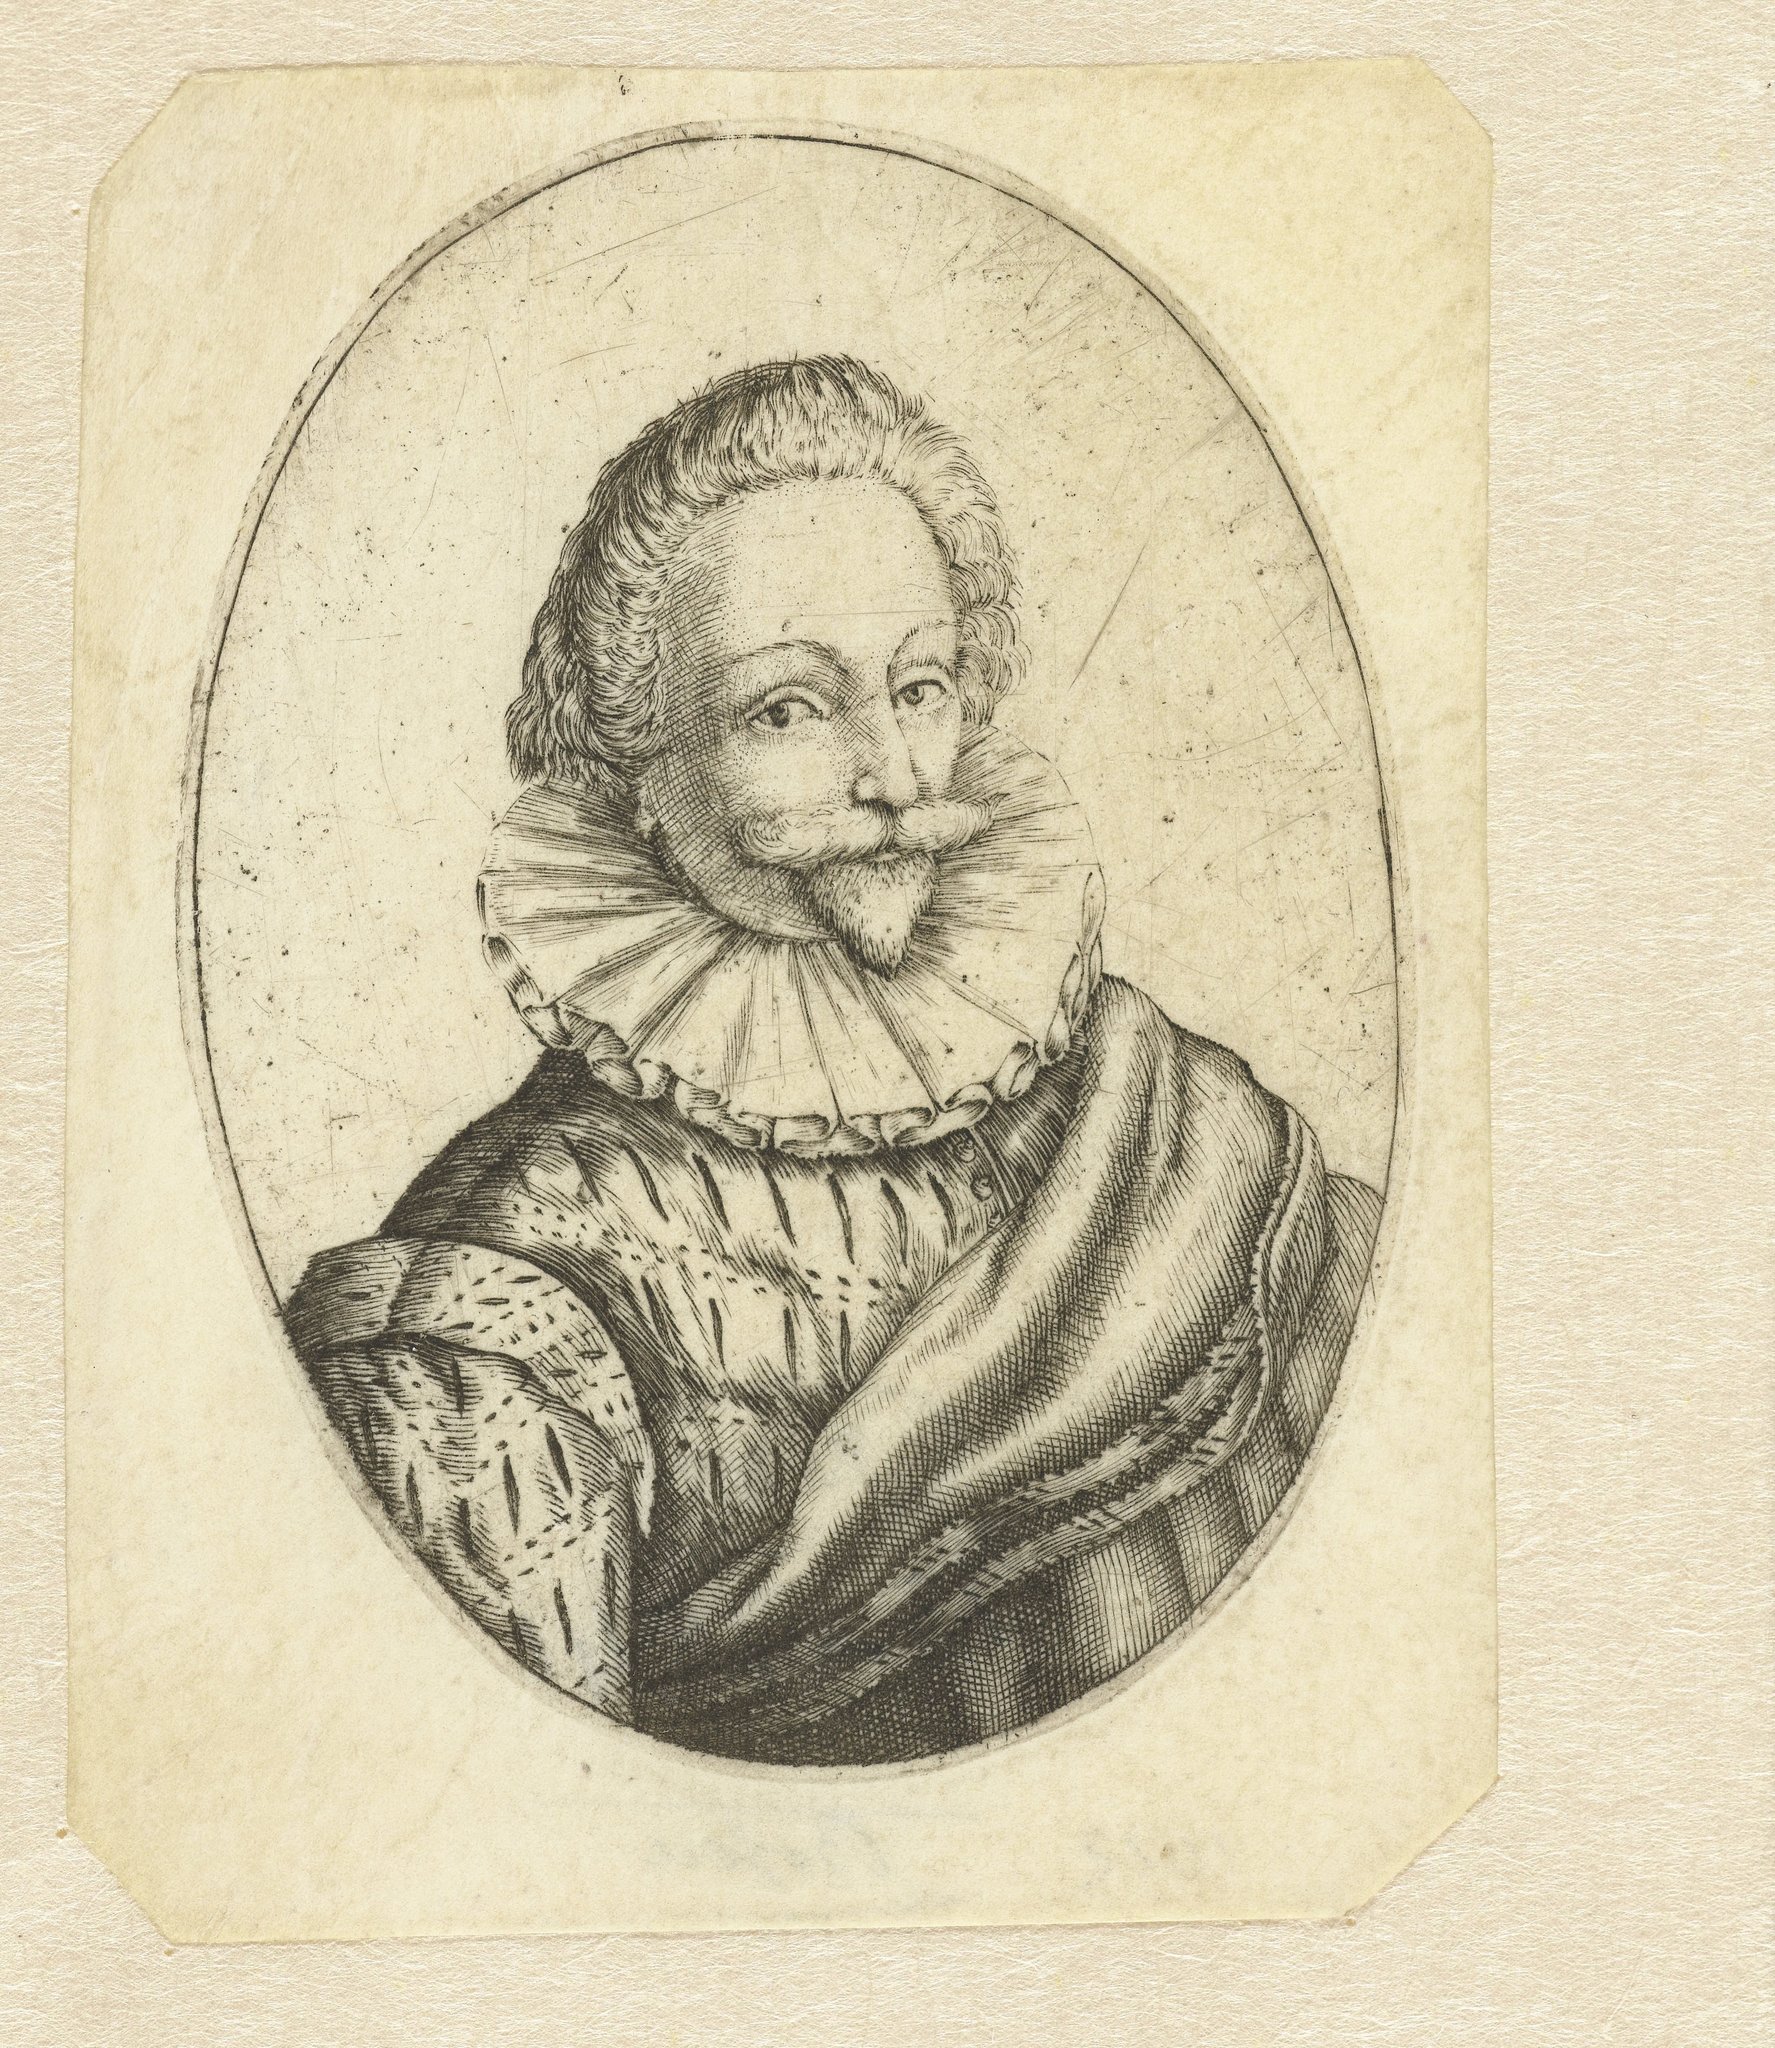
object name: print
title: Portret van een man met snor en baard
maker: Anonymous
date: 1600-1640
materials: parchment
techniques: engraving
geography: netherlands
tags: anonymous historical person portrayed alone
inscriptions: collector's mark: Lugt 2228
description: Portret ten halven lijve in ovaal van een man met een snor en een baard, een mantel, cape of sjerp om de linkerschouder geslagen.